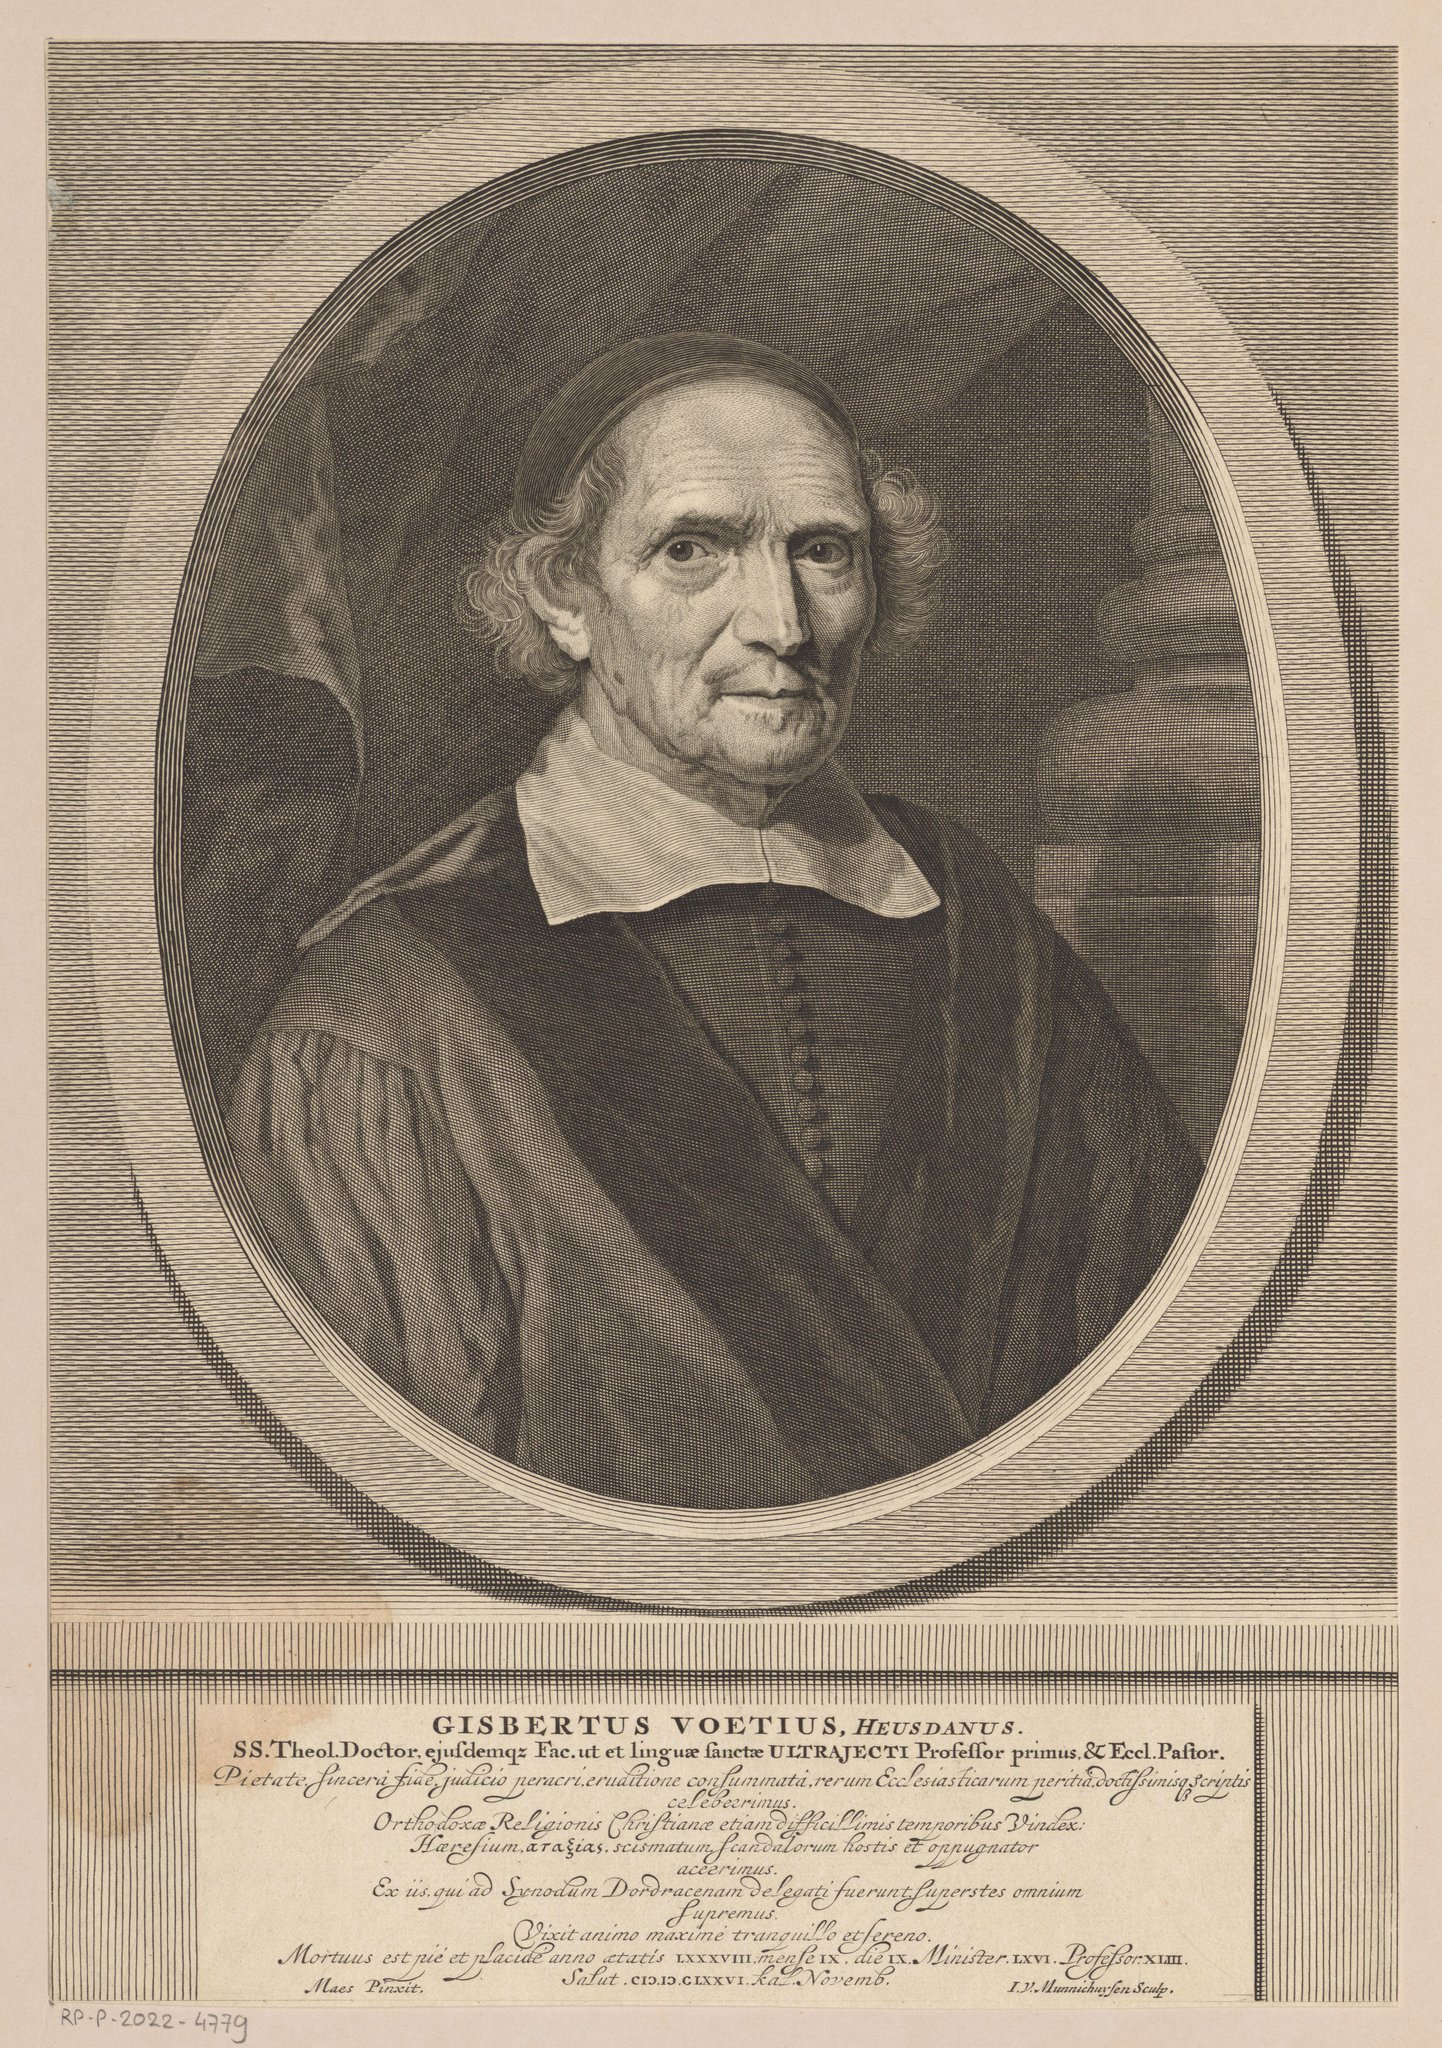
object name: print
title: Portret van Gijsbert Voet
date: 1676-1721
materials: paper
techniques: engraving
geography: northern netherlands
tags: utrecht, theologian, scholar, philosopher, historical persons